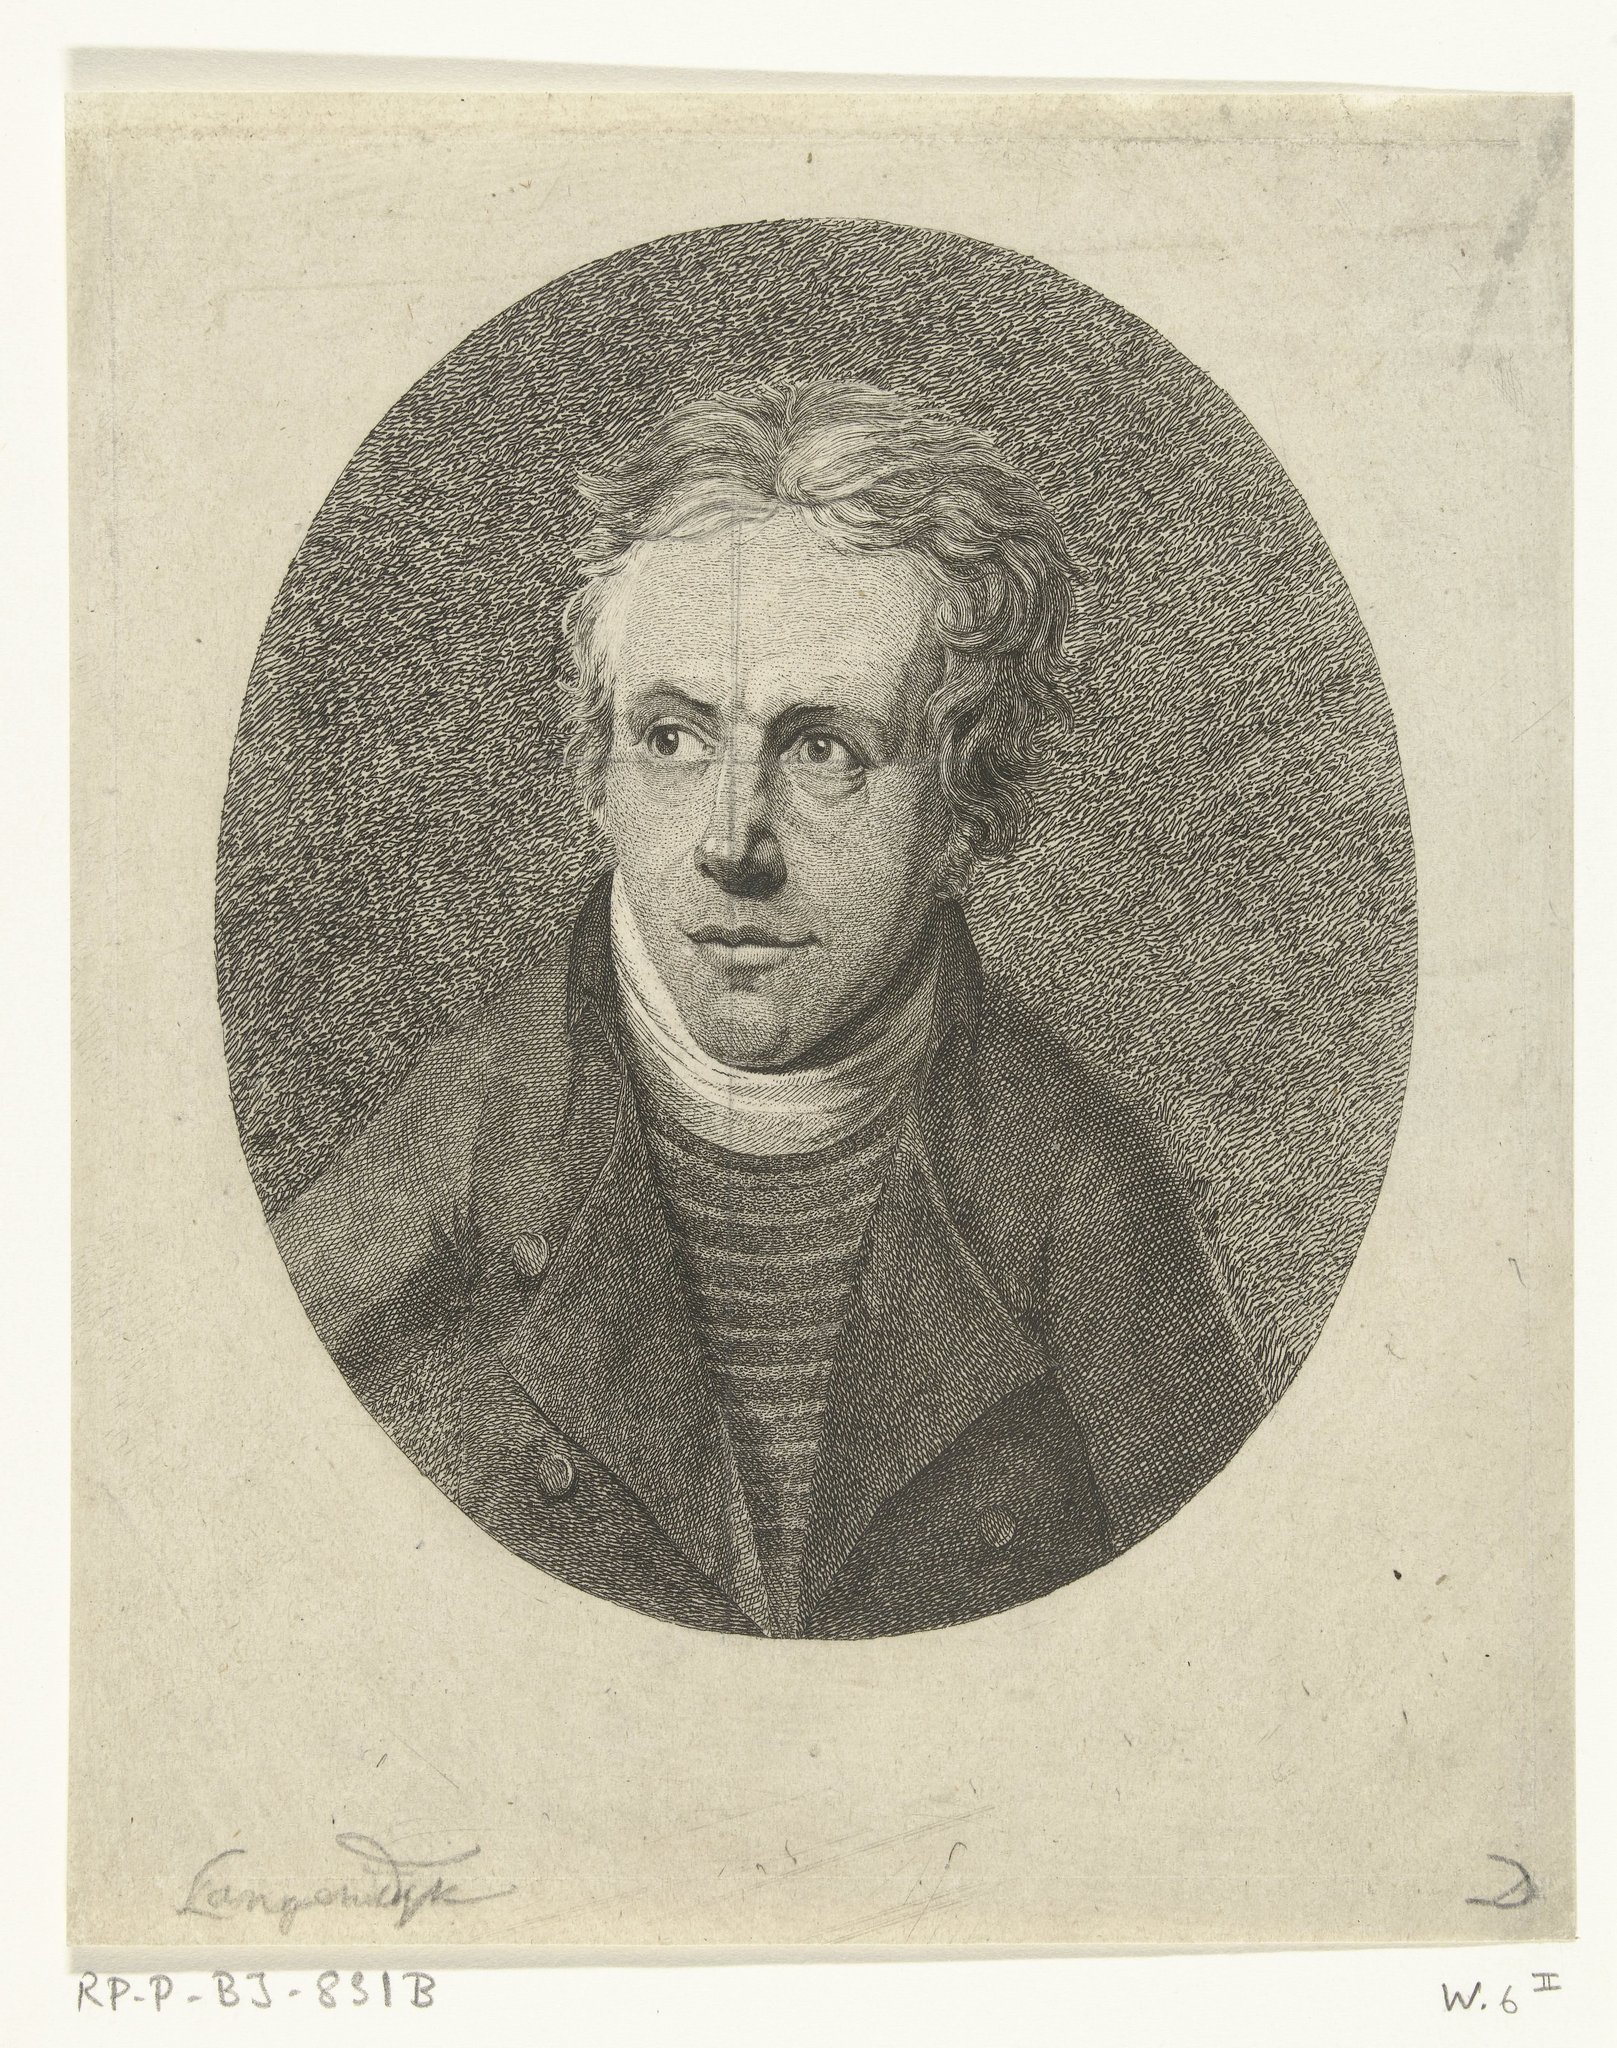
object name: print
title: Portret van Dirk Langendijk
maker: joannes bemme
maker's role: print maker, printer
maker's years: 1775-1841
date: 1805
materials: paper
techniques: etching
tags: rotterdam, painter, print maker, draughtsman, dirk langendijk, art (+ portrait, self-portrait of artist)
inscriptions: collector's mark: Lugt 2228